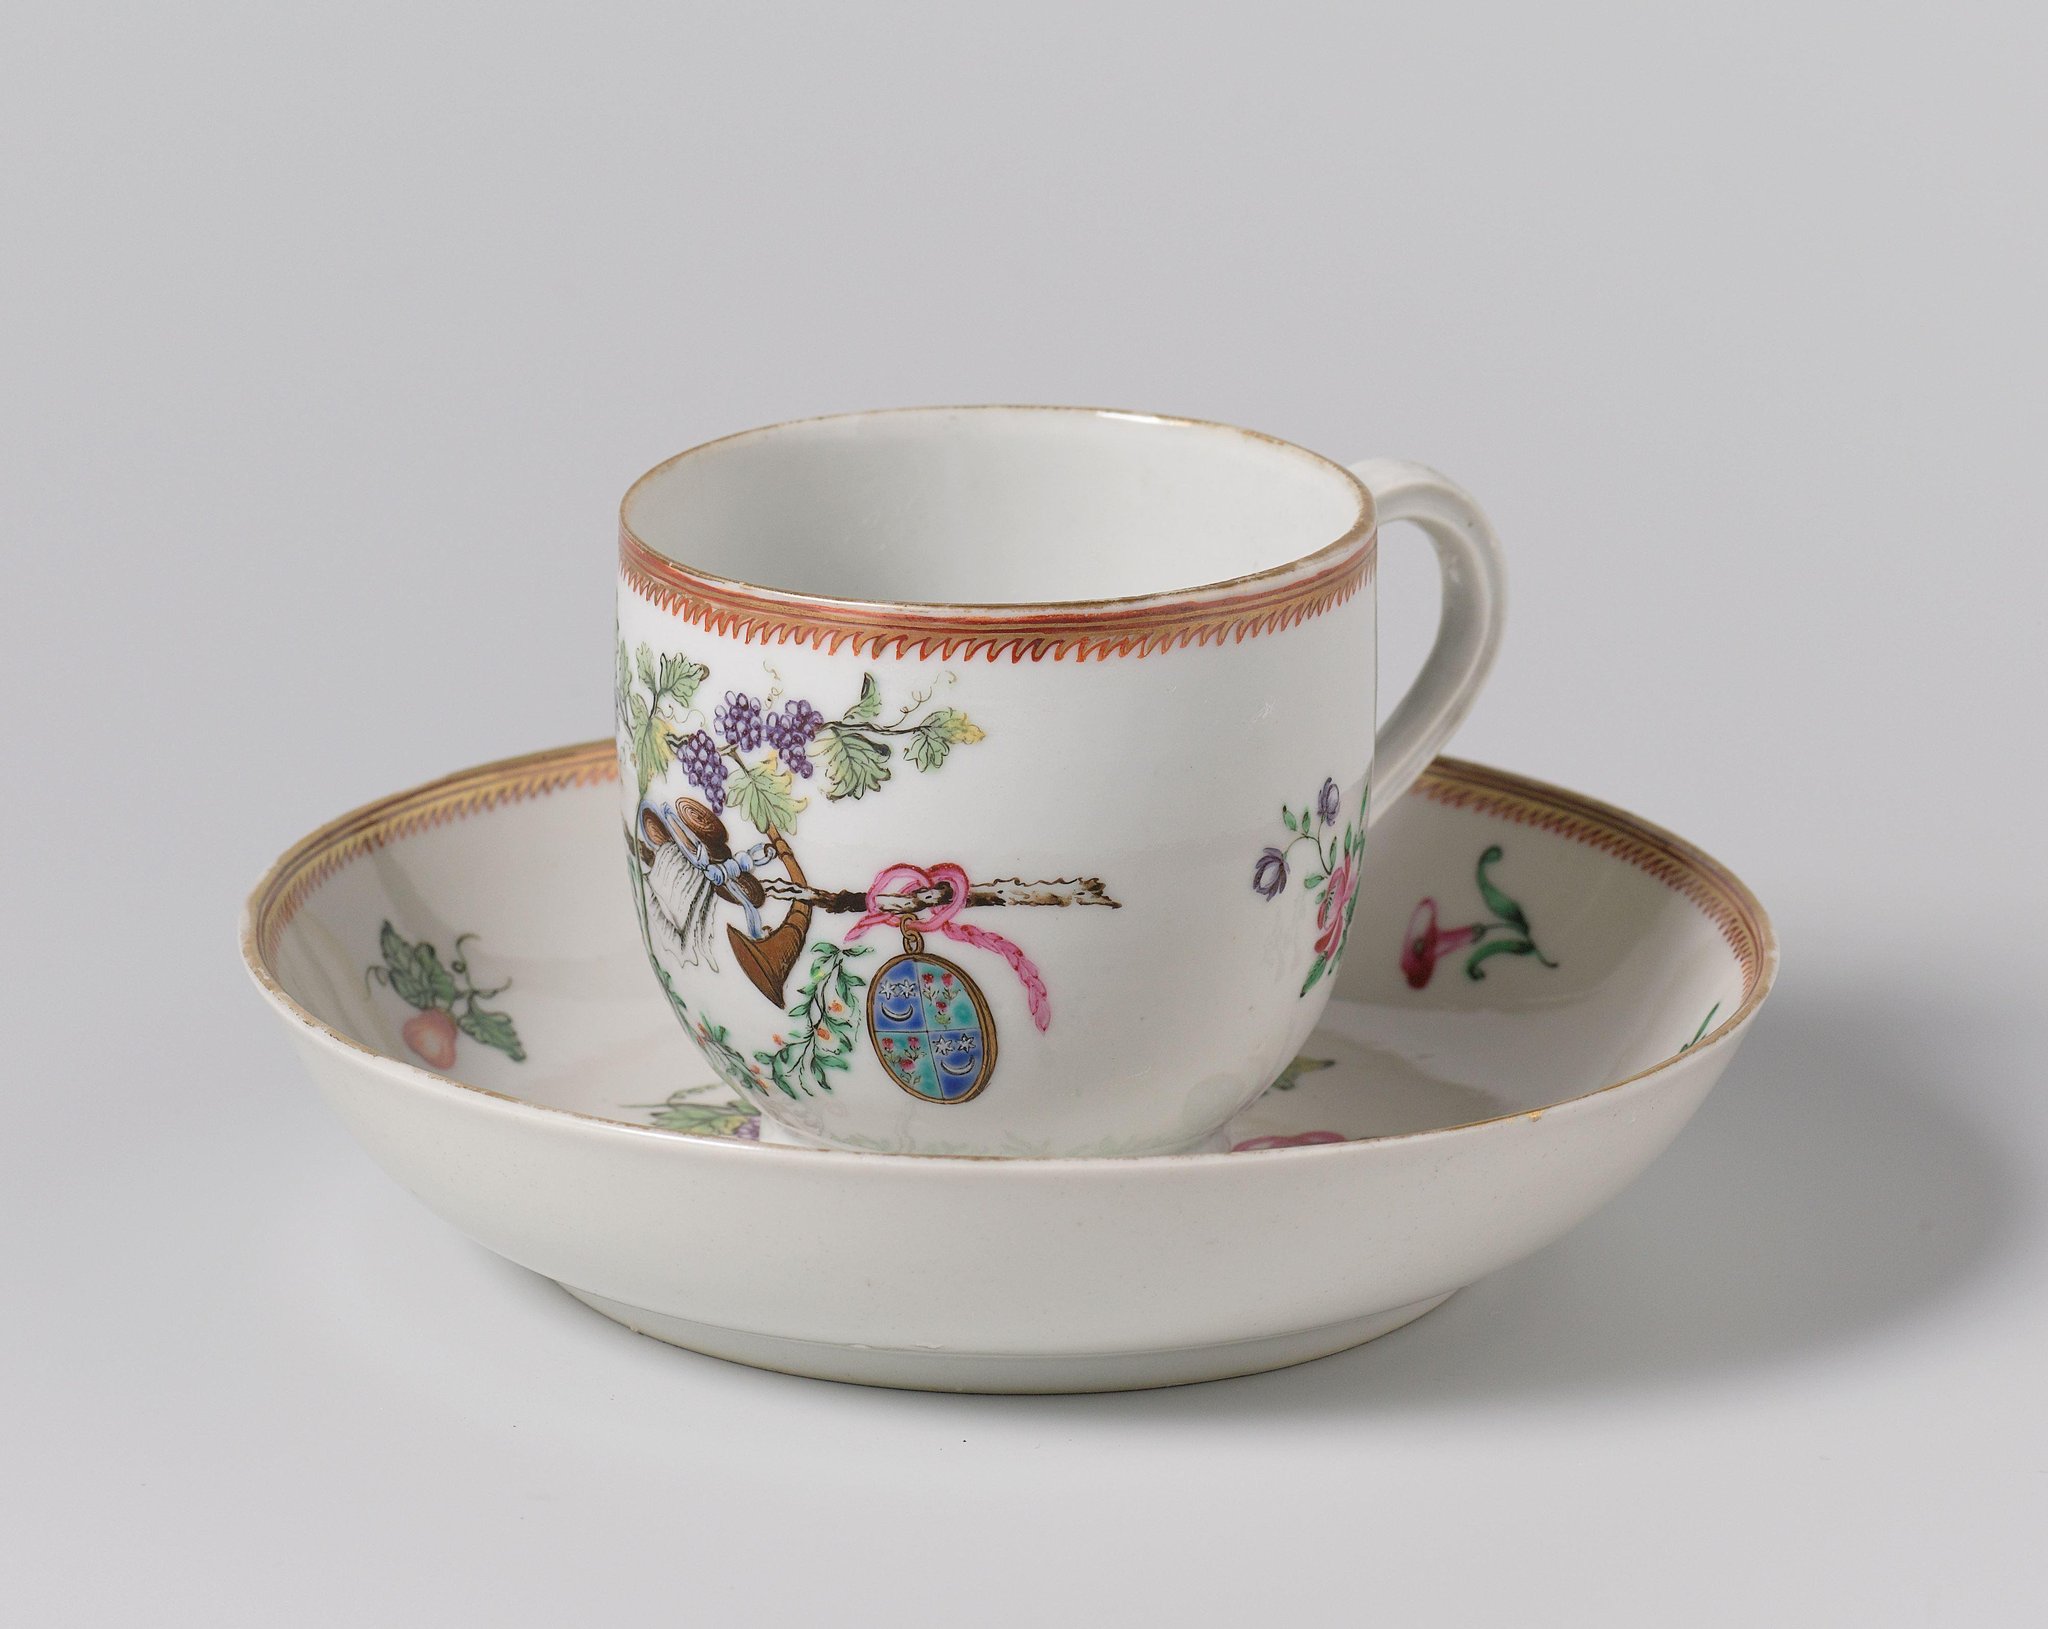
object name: cup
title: Cup with handle with the arms of the Visvliet and Sluymer families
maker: Anonymous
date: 1777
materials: glaze, gold, paint, porcelain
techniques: firing, gilding, turning, vitrification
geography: china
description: Kop en schotel van porselein. Versierd met bloem- en vruchtentakken en een stok waaraan een hoed, een blad papier een hoorn en 2 wapenschilden zijn bevestigd. De wapens zijn van de families Visvliet en Sluymer (uit Zeeland).